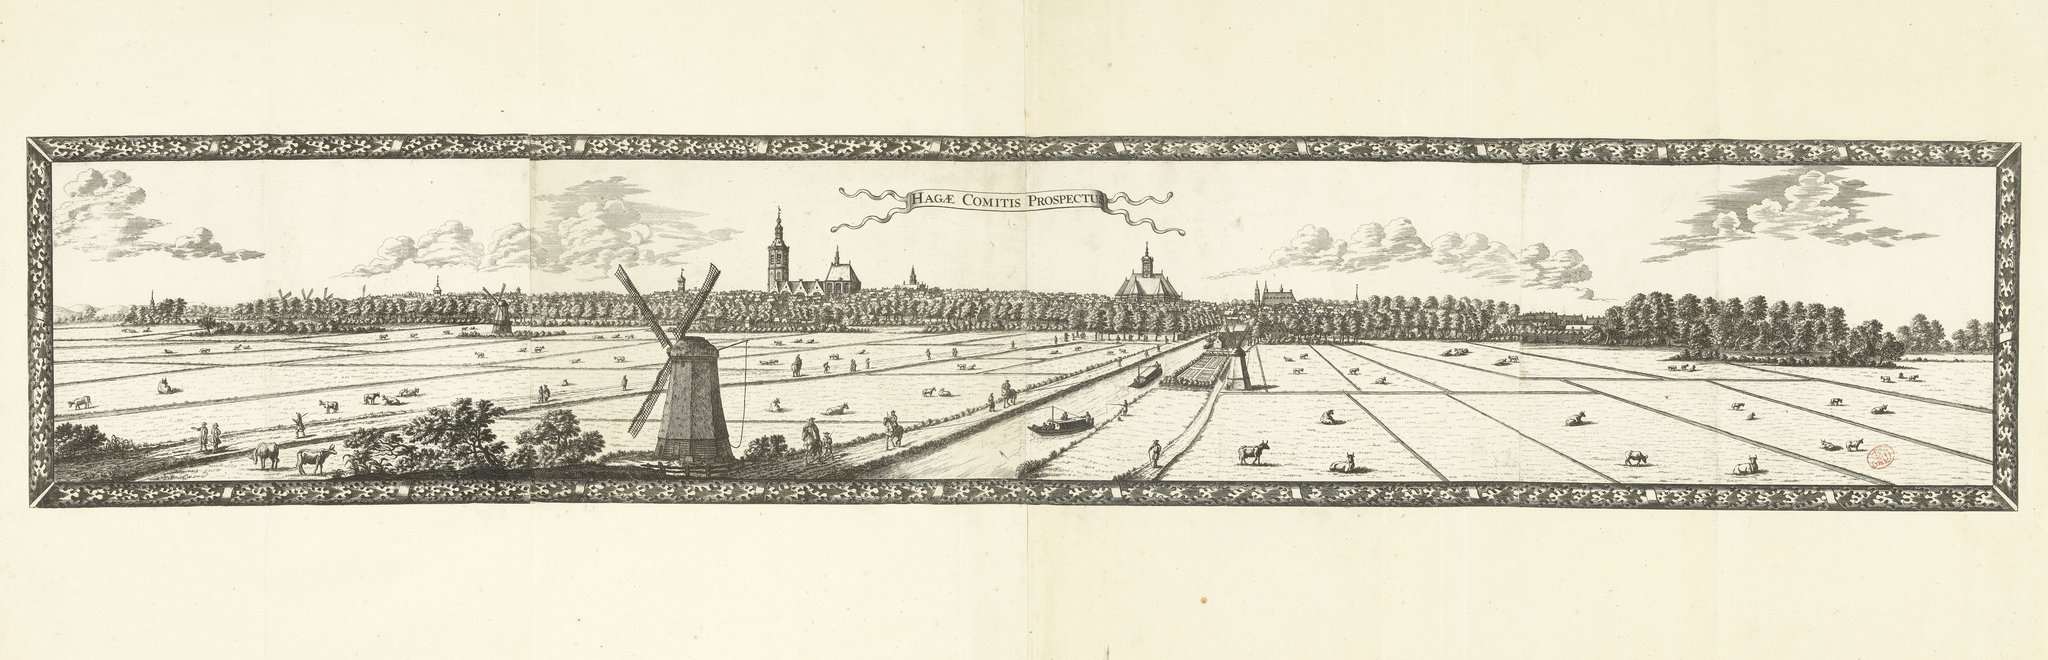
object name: print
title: Panoramisch gezicht op Den Haag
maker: cornelis elandts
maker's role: draughtsman, painter, print maker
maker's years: 1641-1687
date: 1663-1670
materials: paper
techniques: etching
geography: the hague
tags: church (exterior), windmill, prospect of city, town panorama, silhouette of city, boat propelled by man or animal, the hague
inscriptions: collector's mark: Lugt 195, collector's mark: Lugt 2228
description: Deze prent is oorspronkelijk uitgegeven als onderdeel van de rand van de zogenaamde figuratieve kaart van Den Haag uit 1681-1682 (zie RP-P-AO-12-9D). De rand bestond uit een gezicht op de stad en veertien kleinere gezichten in en om Den Haag. De vijftien prenten van de rand zijn later ook gebruikt in: Aa, Pieter van der. La galerie agreable du monde (...). 66 delen. Leiden: Pieter van der Aa, 1728, dl. 18 en 19. De huidige prent komt voor in dl. 19. Voor de overige prenten van de rand, zie: RP-P-AO-12-8-2, RP-P-OB-50.201, RP-P-OB-50.202, RP-P-OB-50.203, RP-P-OB-50.204, RP-P-OB-50.205, RP-P-OB-50.206, RP-P-OB-50.207, RP-P-OB-50.208, RP-P-OB-50.209, RP-P-OB-50.210, RP-P-OB-50.211, RP-P-OB-50.212, RP-P-OB-50.213, en RP-P-OB-50.214.